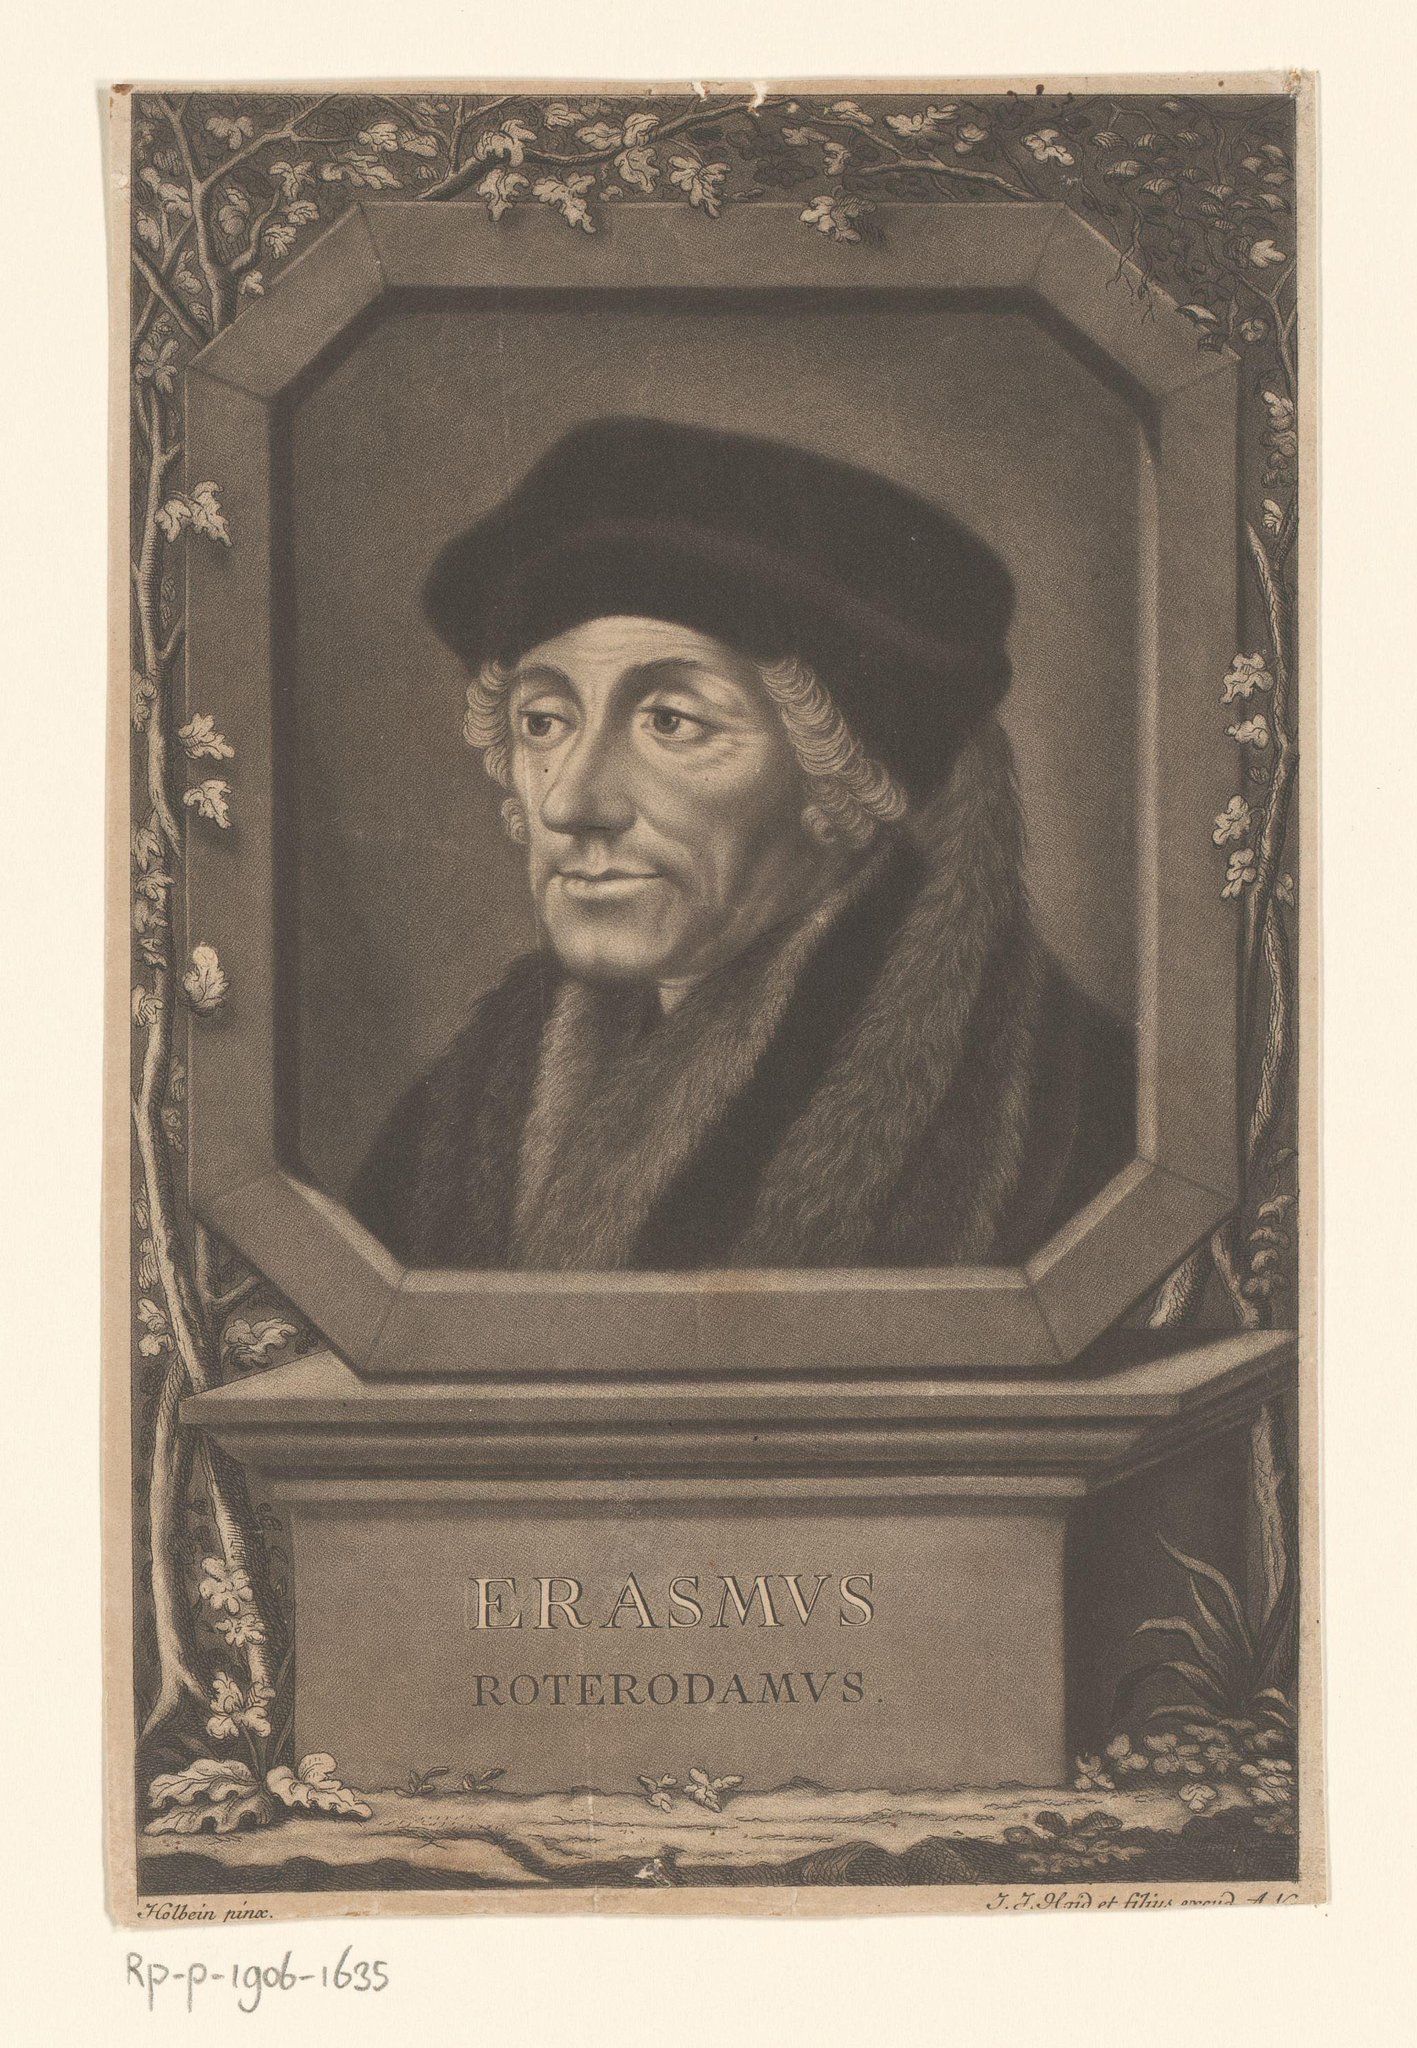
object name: print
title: Portret van Desiderius Erasmus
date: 1714-1767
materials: paper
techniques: etching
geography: augsburg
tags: rotterdam, desiderius erasmus, fantastic plants, fabulous vegetation, historical persons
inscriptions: collector's mark: Lugt 2228